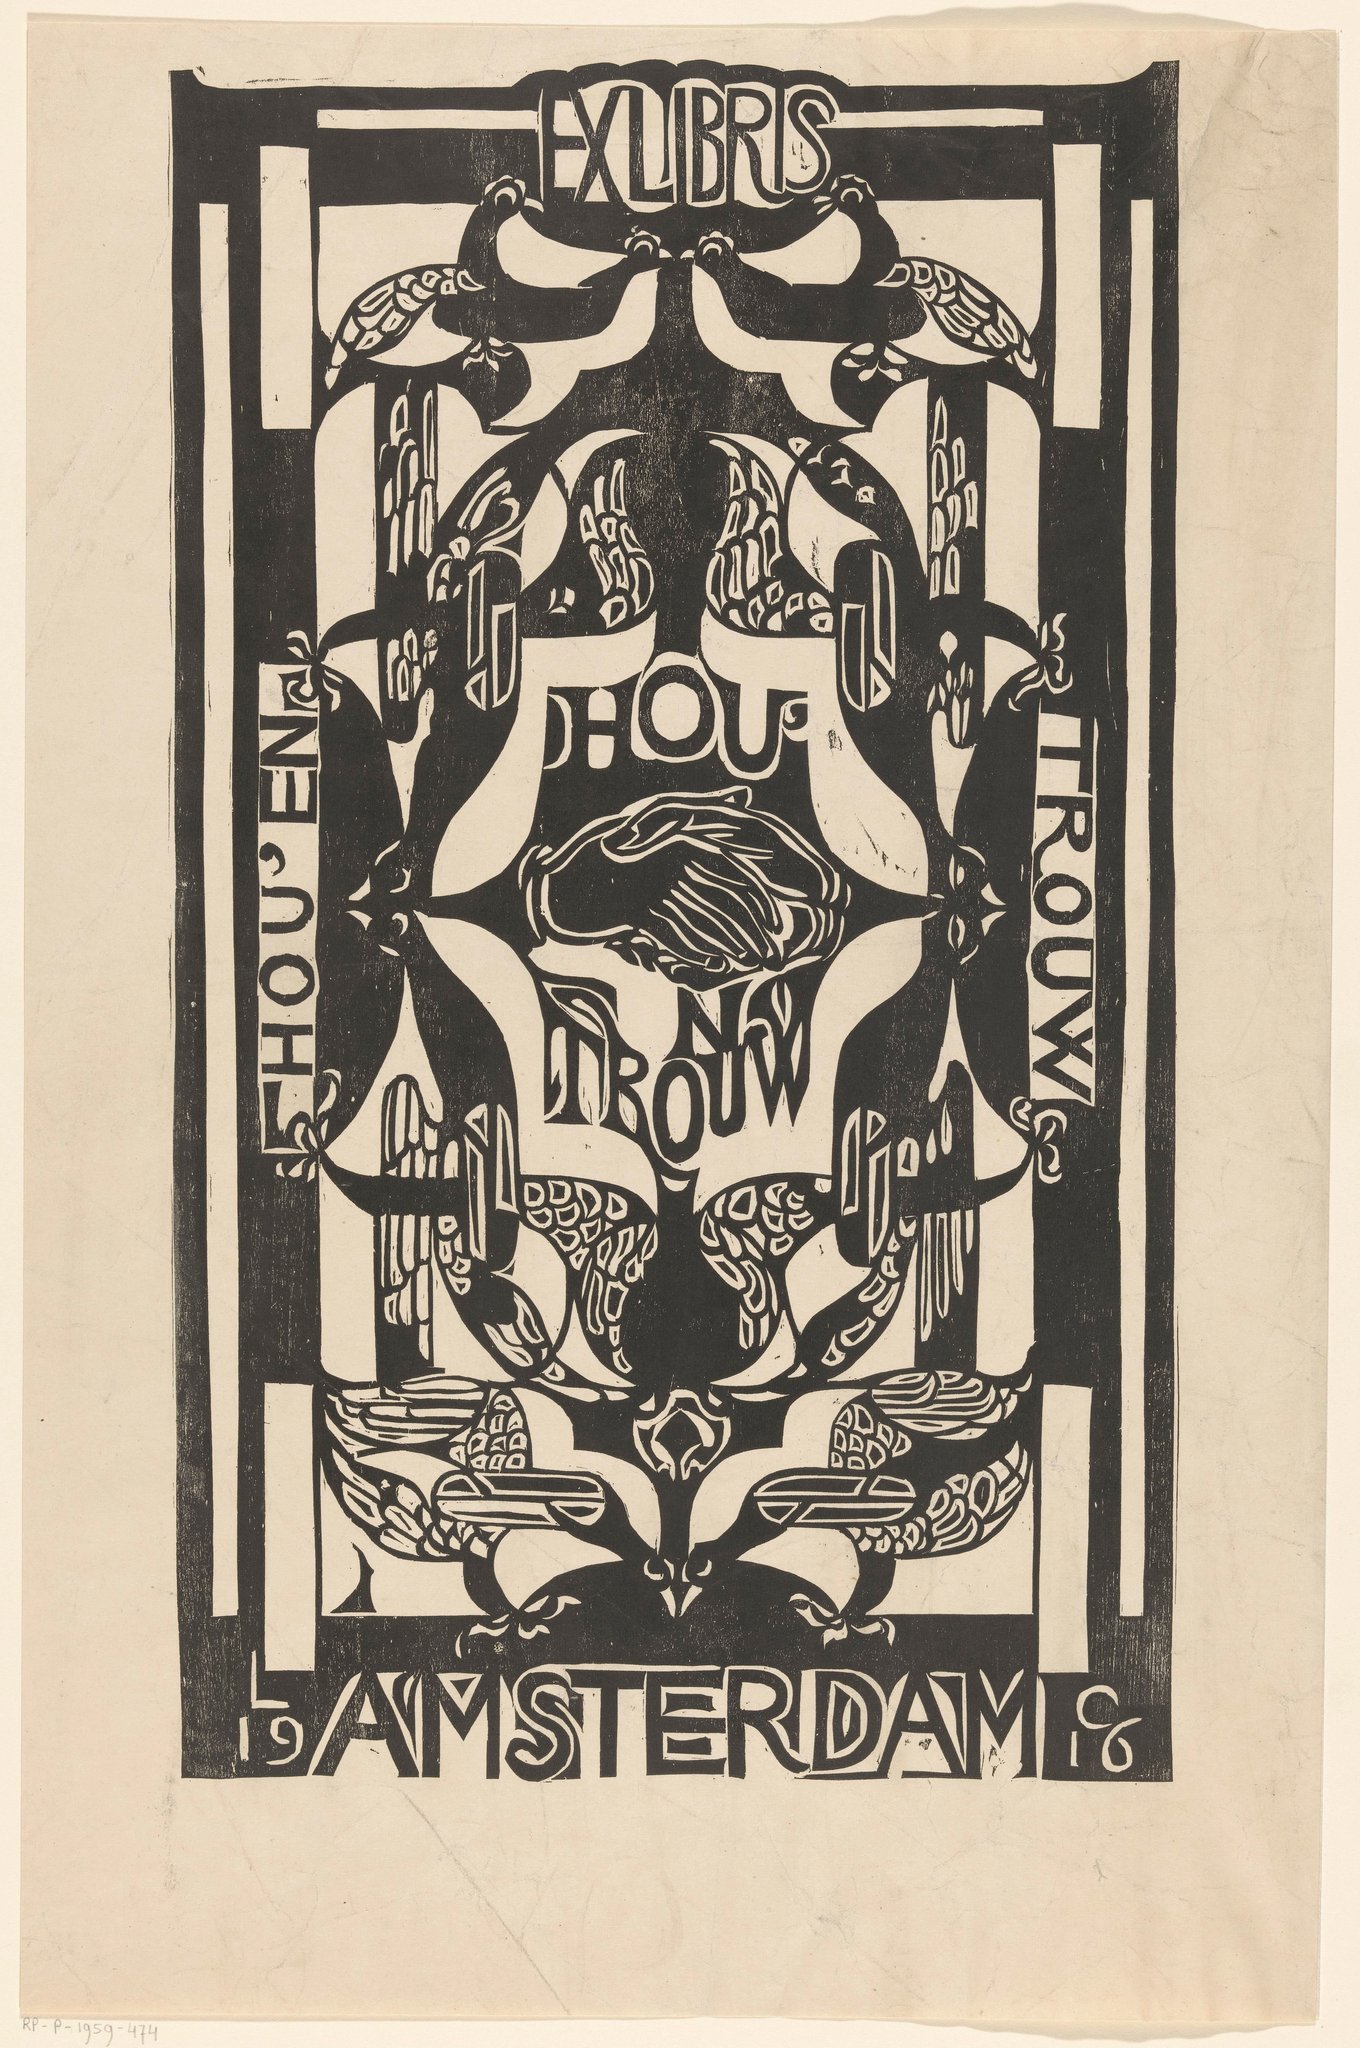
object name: print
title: Ex libris van de vereniging Hou'en Trouw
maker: carel adolph lion cachet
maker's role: draughtsman, print maker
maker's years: 1864-1945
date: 1916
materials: paper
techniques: woodcut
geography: amsterdam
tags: shaking hands, 'dextrarum junctio', birds, amsterdam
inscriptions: collector's mark: Lugt 2228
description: In het midden twee handen die elkaar schudden. Links verticaal 'Hou' en', rechts verticaal 'trouw'. Boven en onder gestileerde vogels.